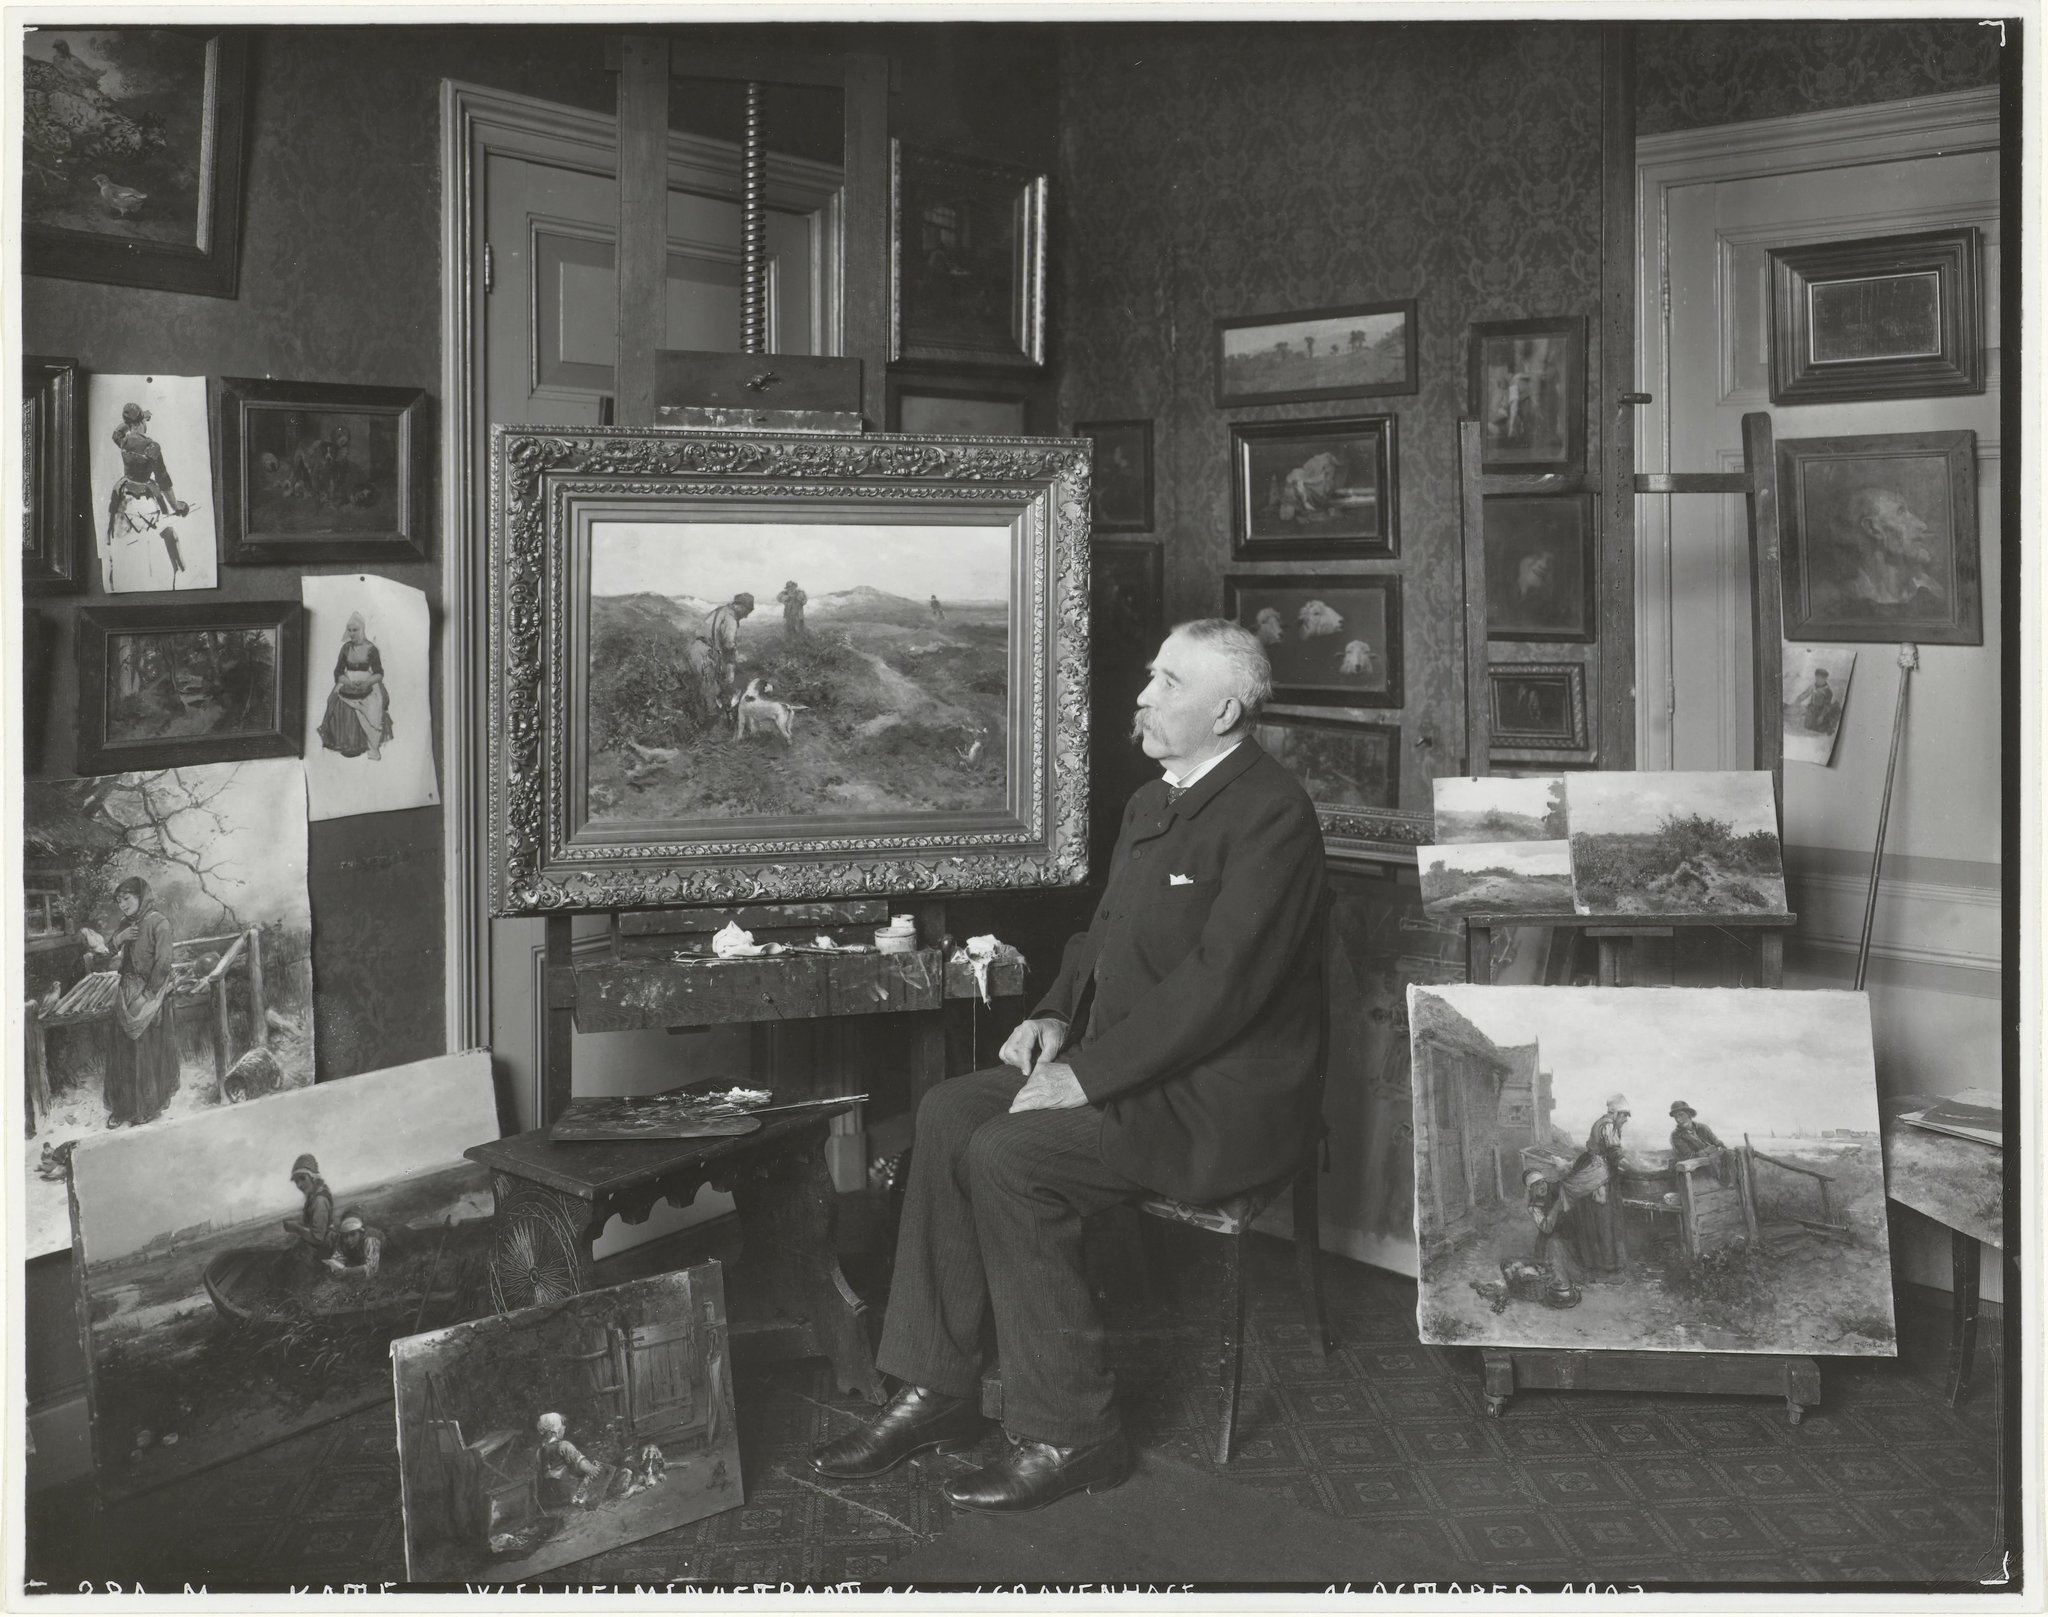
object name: later print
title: Mari ten Kate in zijn atelier in de Wilhelminastraat 14 in Den Haag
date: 1903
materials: paper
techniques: gelatin silver print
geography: the hague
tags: the hague, painter, print maker, draughtsman, mari ten kate, painter at work, in his studio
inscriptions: copyright notice: ‘World Copyright by W.M.A. Deppe, Bachlaan, 1 Naarden (Holland) telef. K 2959-5505’, inscription: ‘28A M. KATE WILHELMINASTRAAT 14 'S GRAVEHAGE/ 16 OCTOBER 1903’